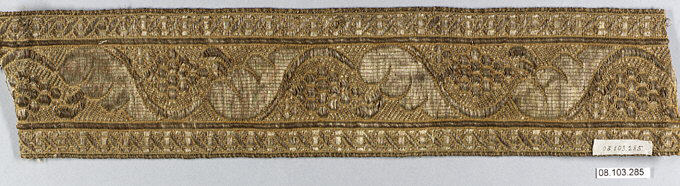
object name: galloon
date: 1601-1800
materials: metal thread